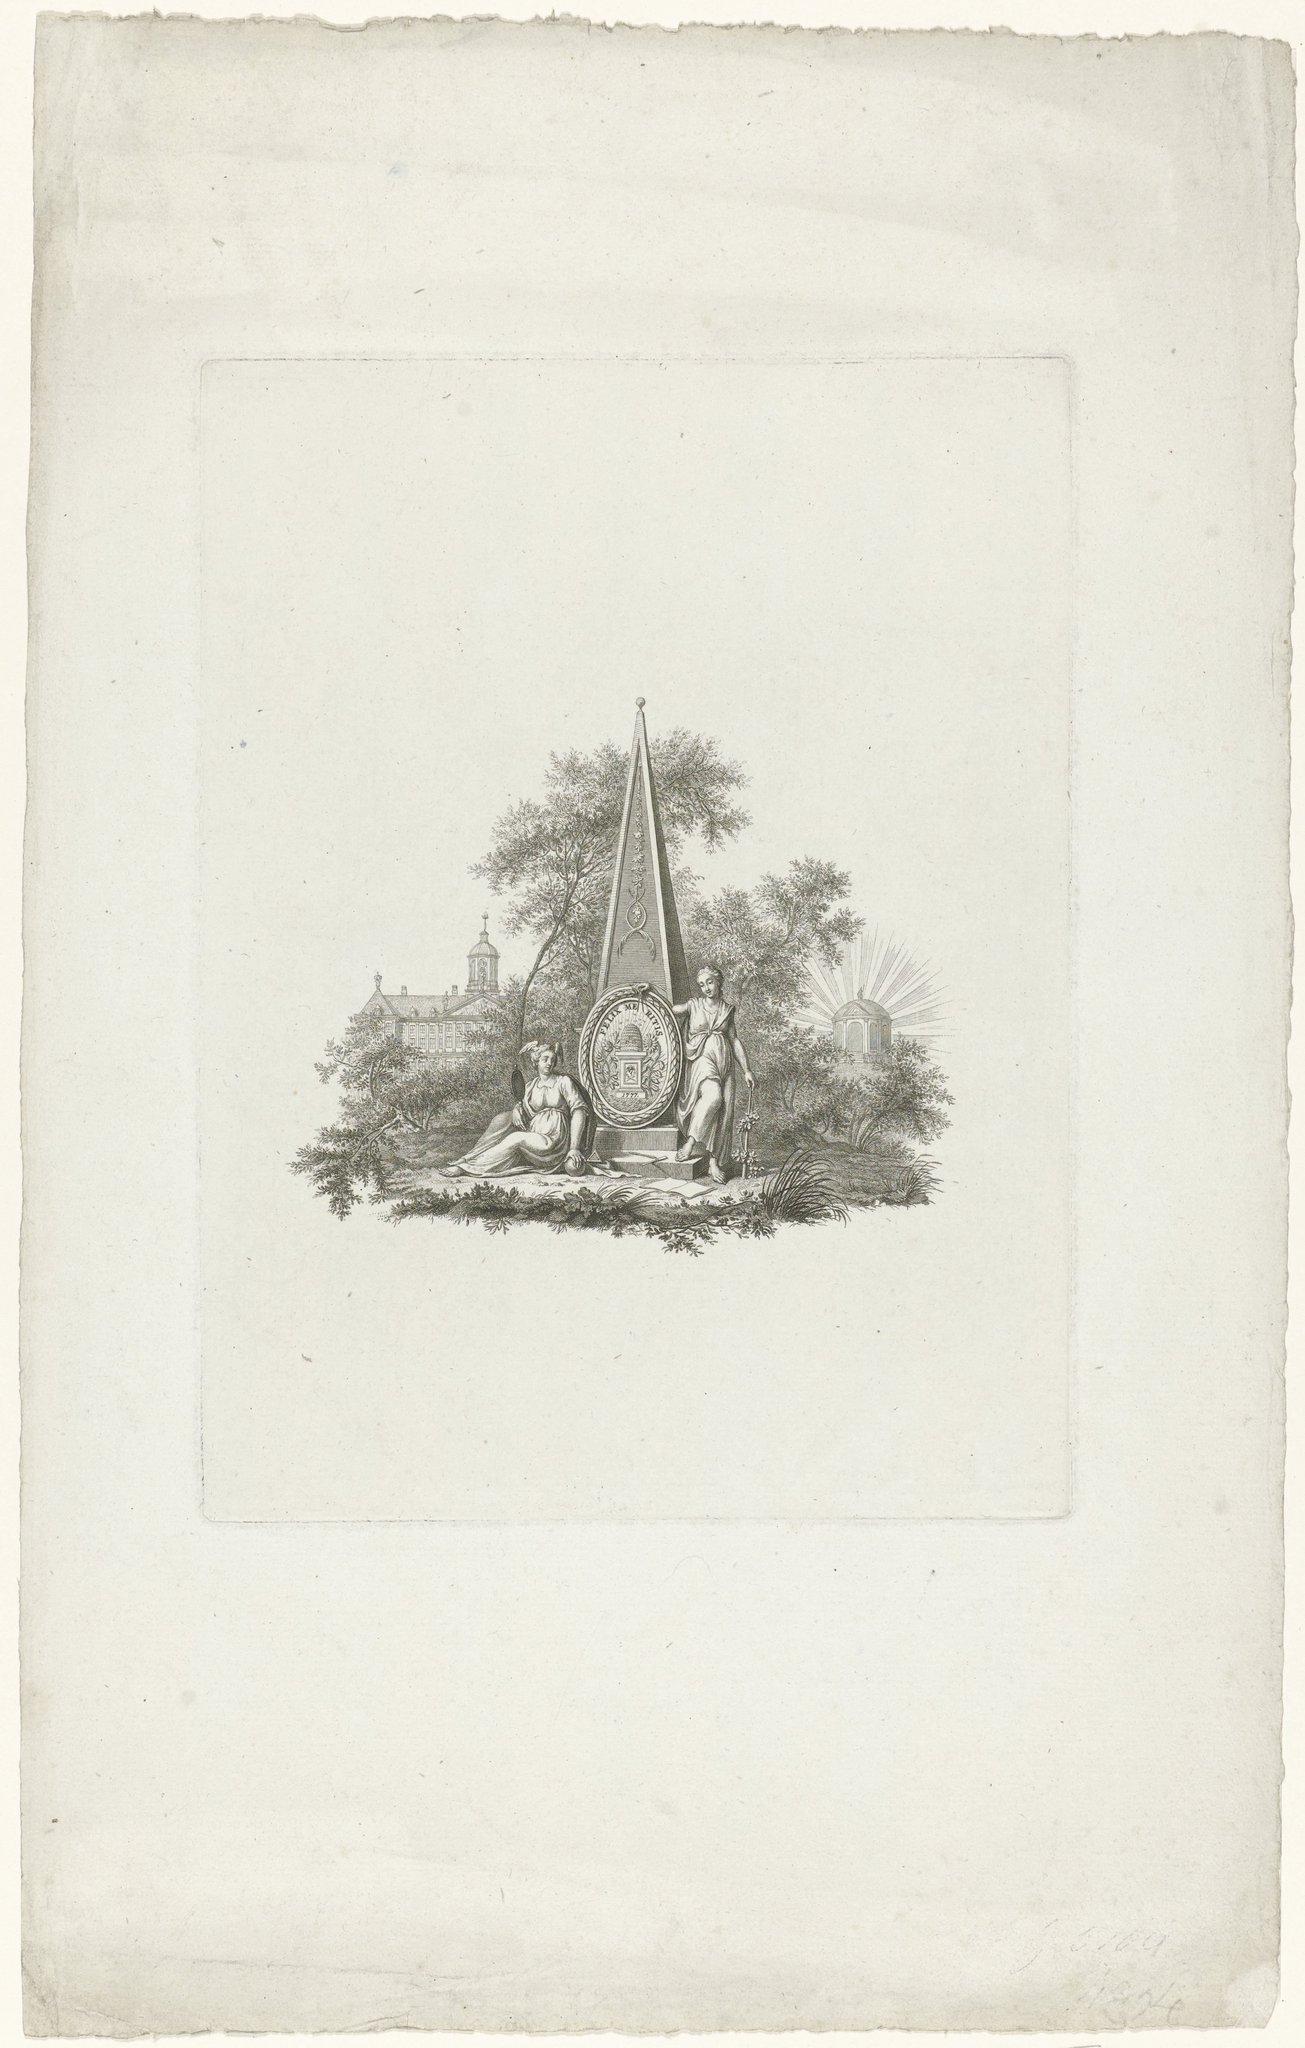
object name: print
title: Allegorie op de stichting van Felix Meritis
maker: noach van der meer (ii)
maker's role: draughtsman, print maker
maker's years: 1741-1822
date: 1781-1783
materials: paper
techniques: engraving, etching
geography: northern netherlands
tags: felix meritis, stadhuis van amsterdam (1655-1808)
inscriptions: collector's mark: Lugt 2228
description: Titelpagina met een allegorisch vignet op de stichting van de maatschappij Felix Meritis te Amsterdam, 1 november 1777. Twee allegorische vrouwenfiguren ter weerszijden van een obelisk met het vignet van Felix Meritis, op de achtergrond het stadhuis en een stralende tempel.